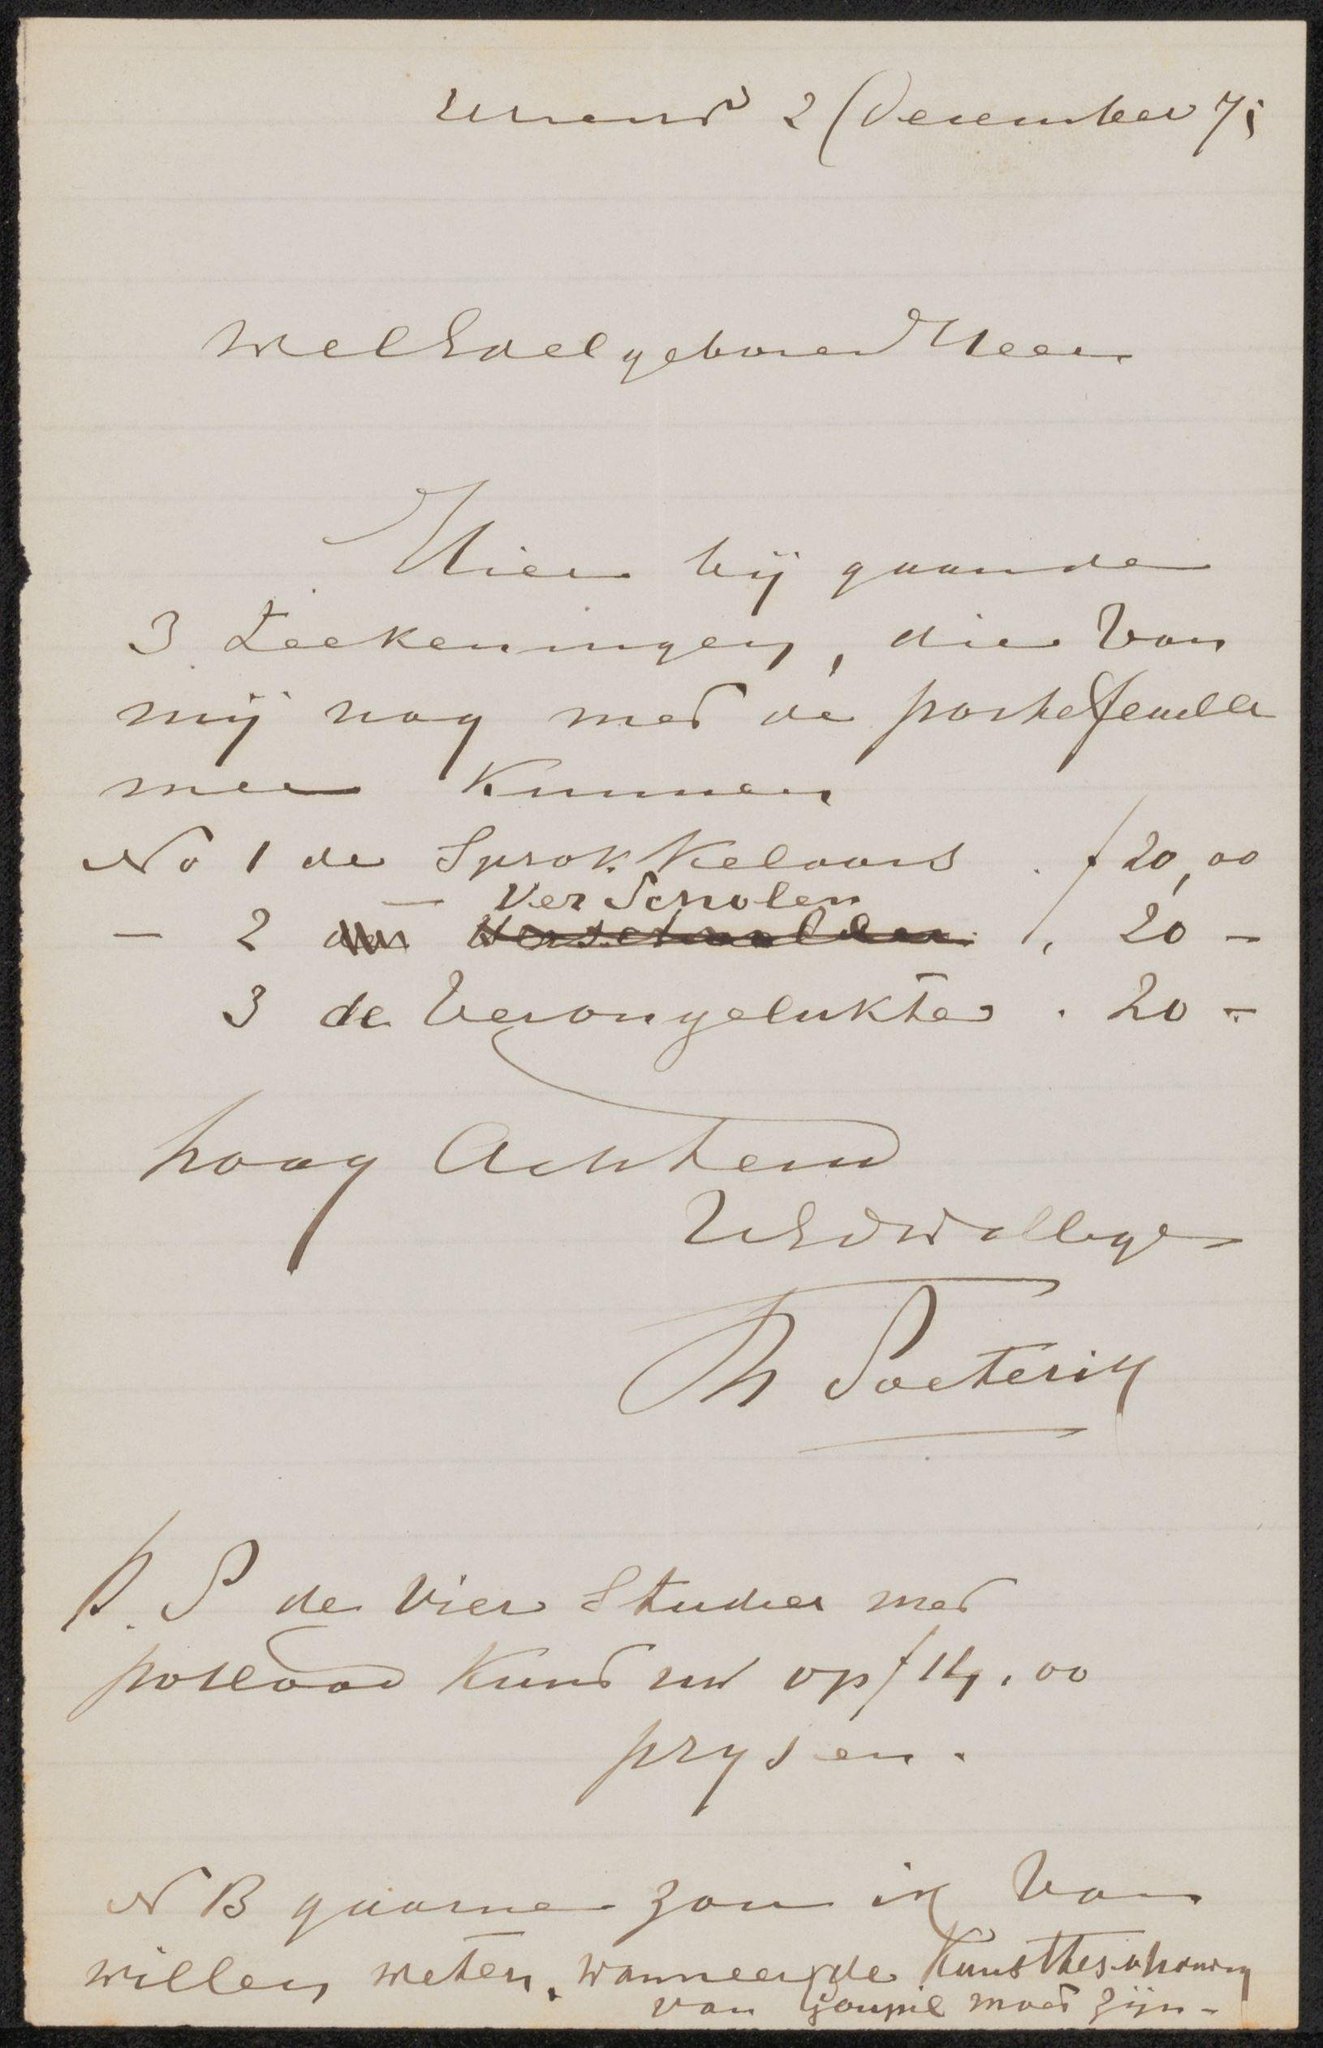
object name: letter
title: Brief aan anoniem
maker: theodoor soeterik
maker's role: draughtsman, print maker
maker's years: 1810-1883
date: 1875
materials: ink, paper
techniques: pen, writing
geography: utrecht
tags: drawing, money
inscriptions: collector's mark: ‘RPK’